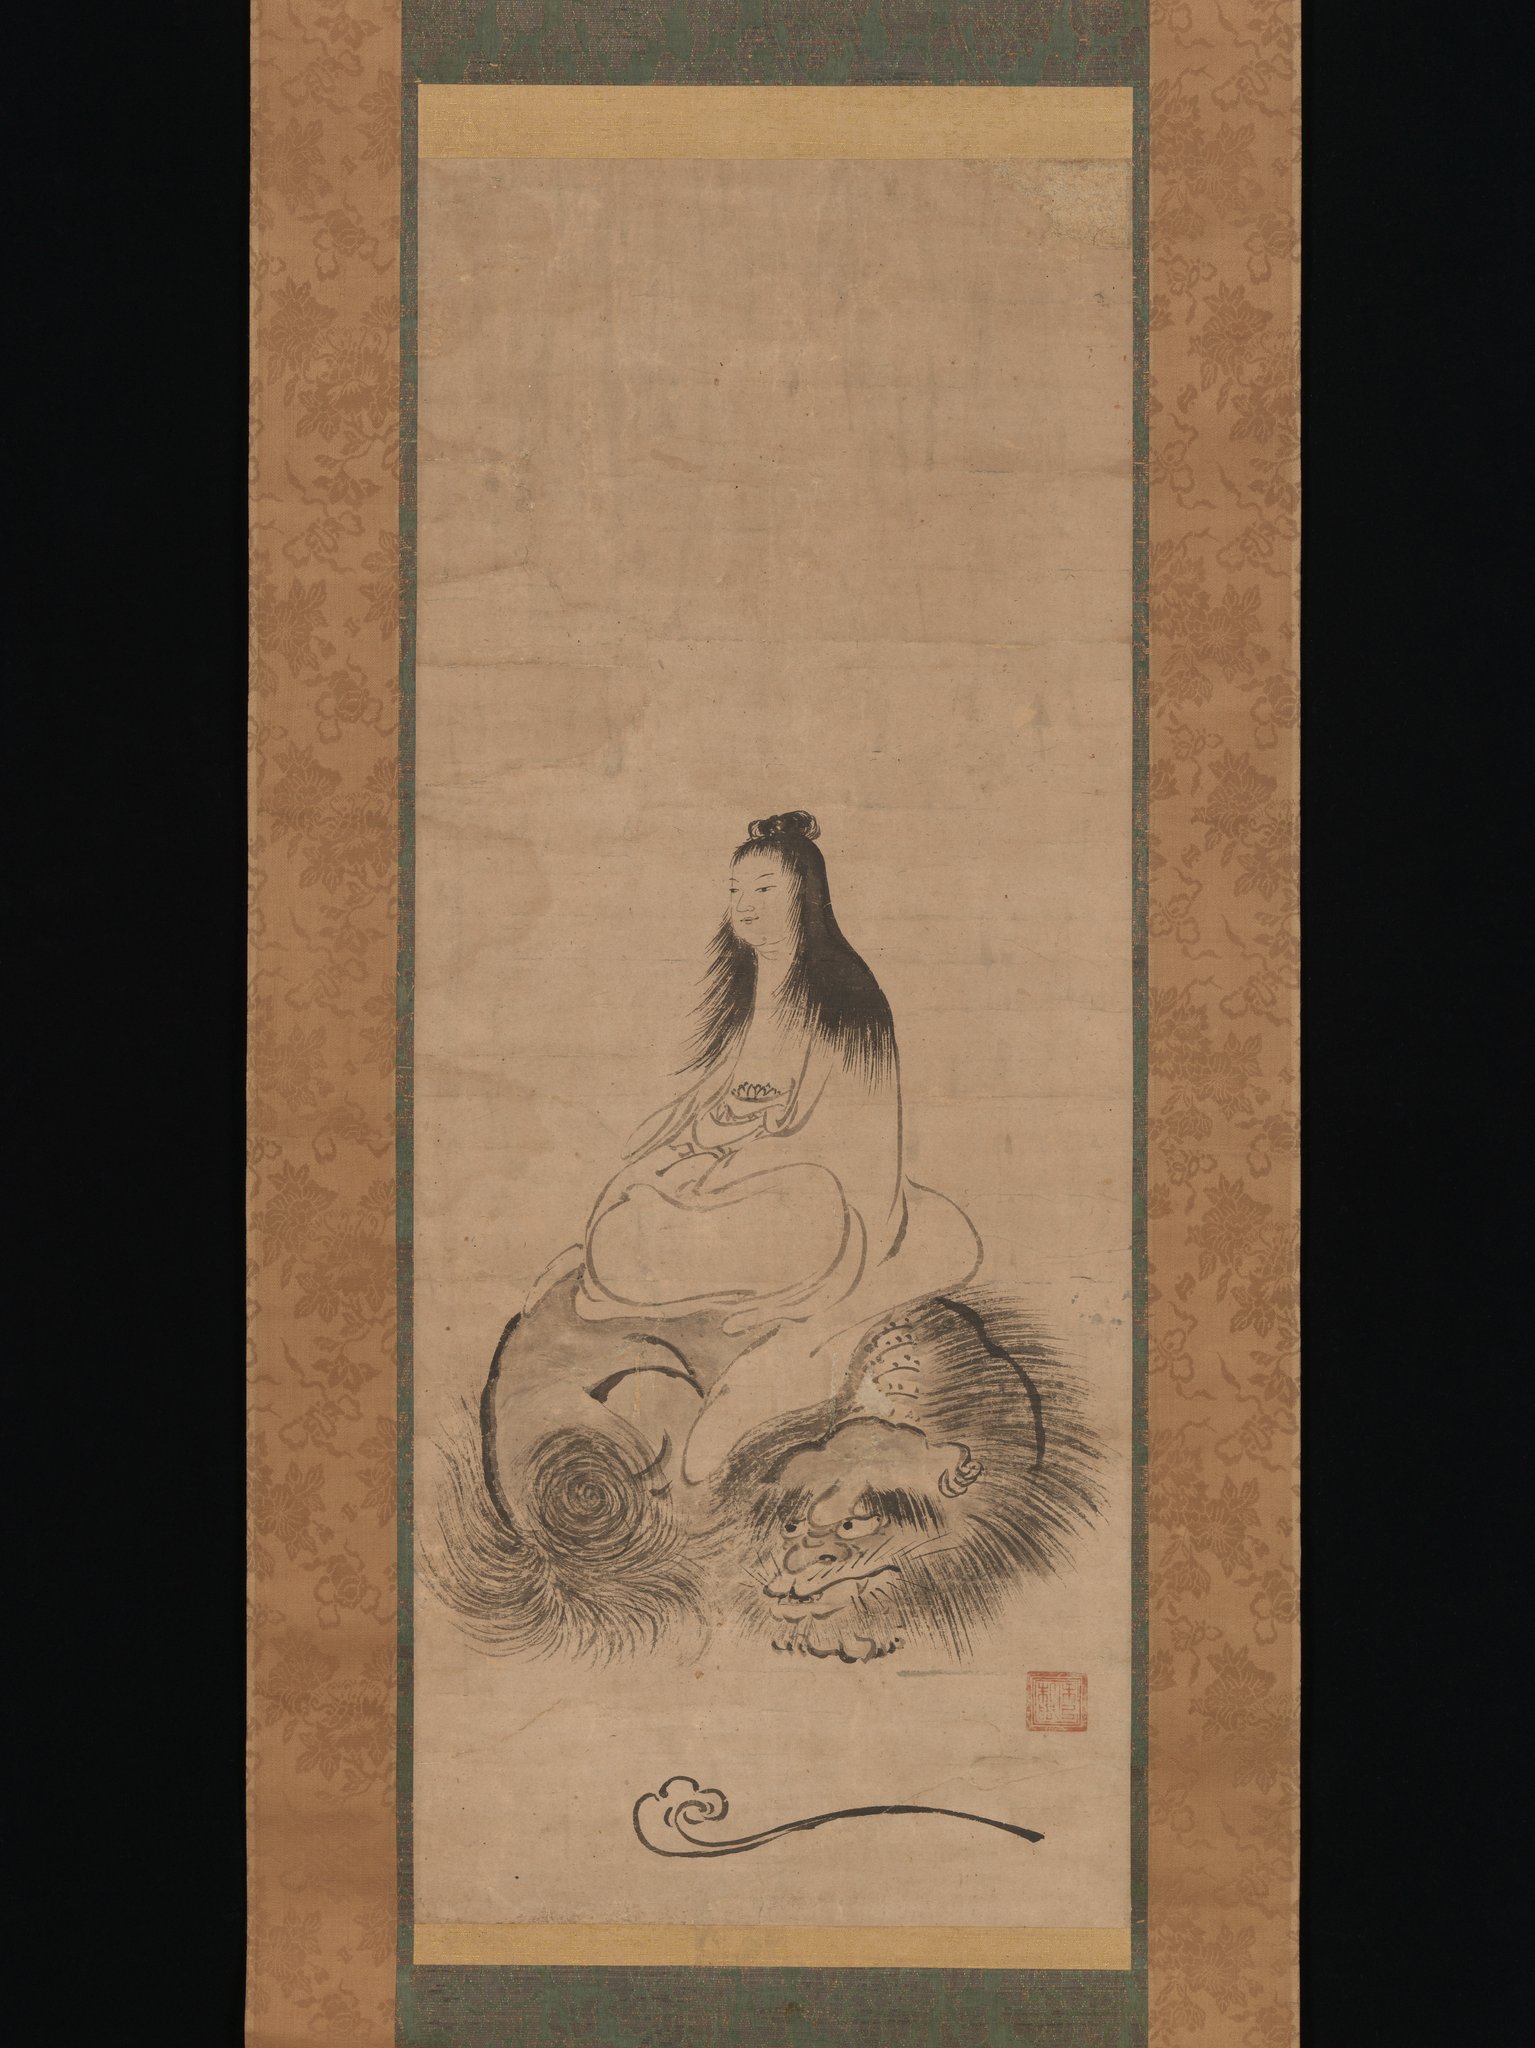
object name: hanging scroll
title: Monju on a Lion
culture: japanese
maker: shūsei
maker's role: artist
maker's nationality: japanese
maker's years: 1467-1499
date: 1467-1500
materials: ink, paper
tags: lions,bodhisattvas,manjushri